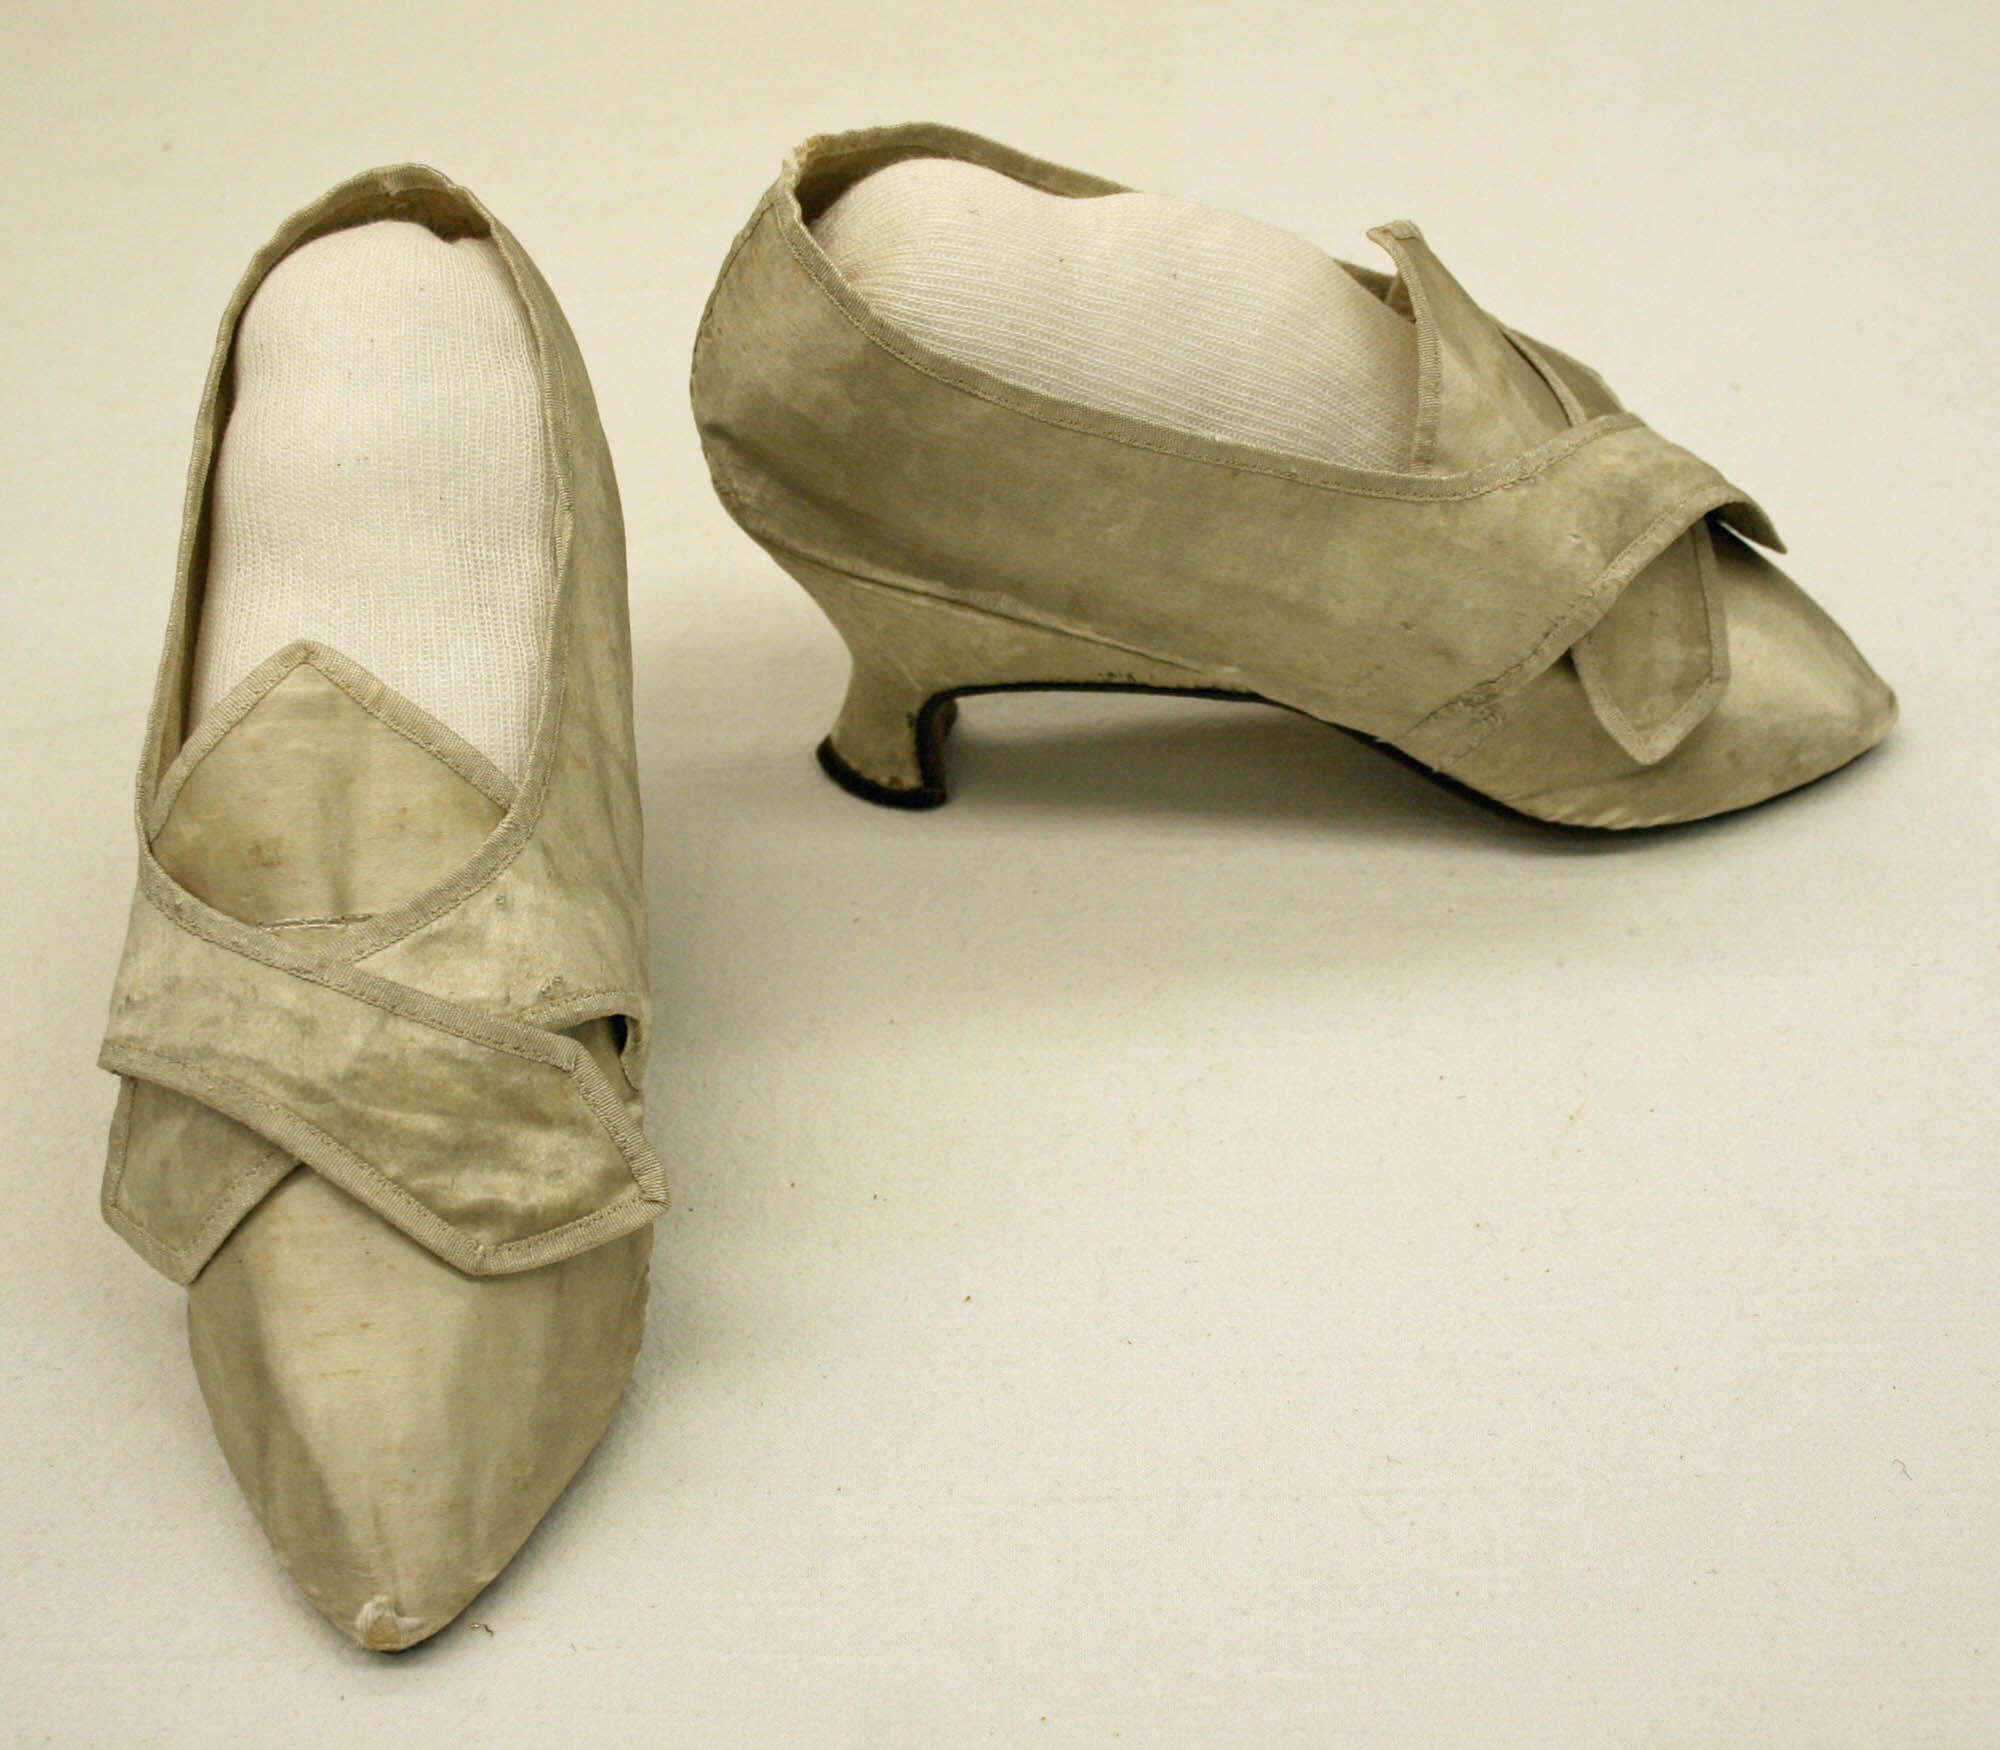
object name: shoe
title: Shoes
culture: american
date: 1780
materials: silk